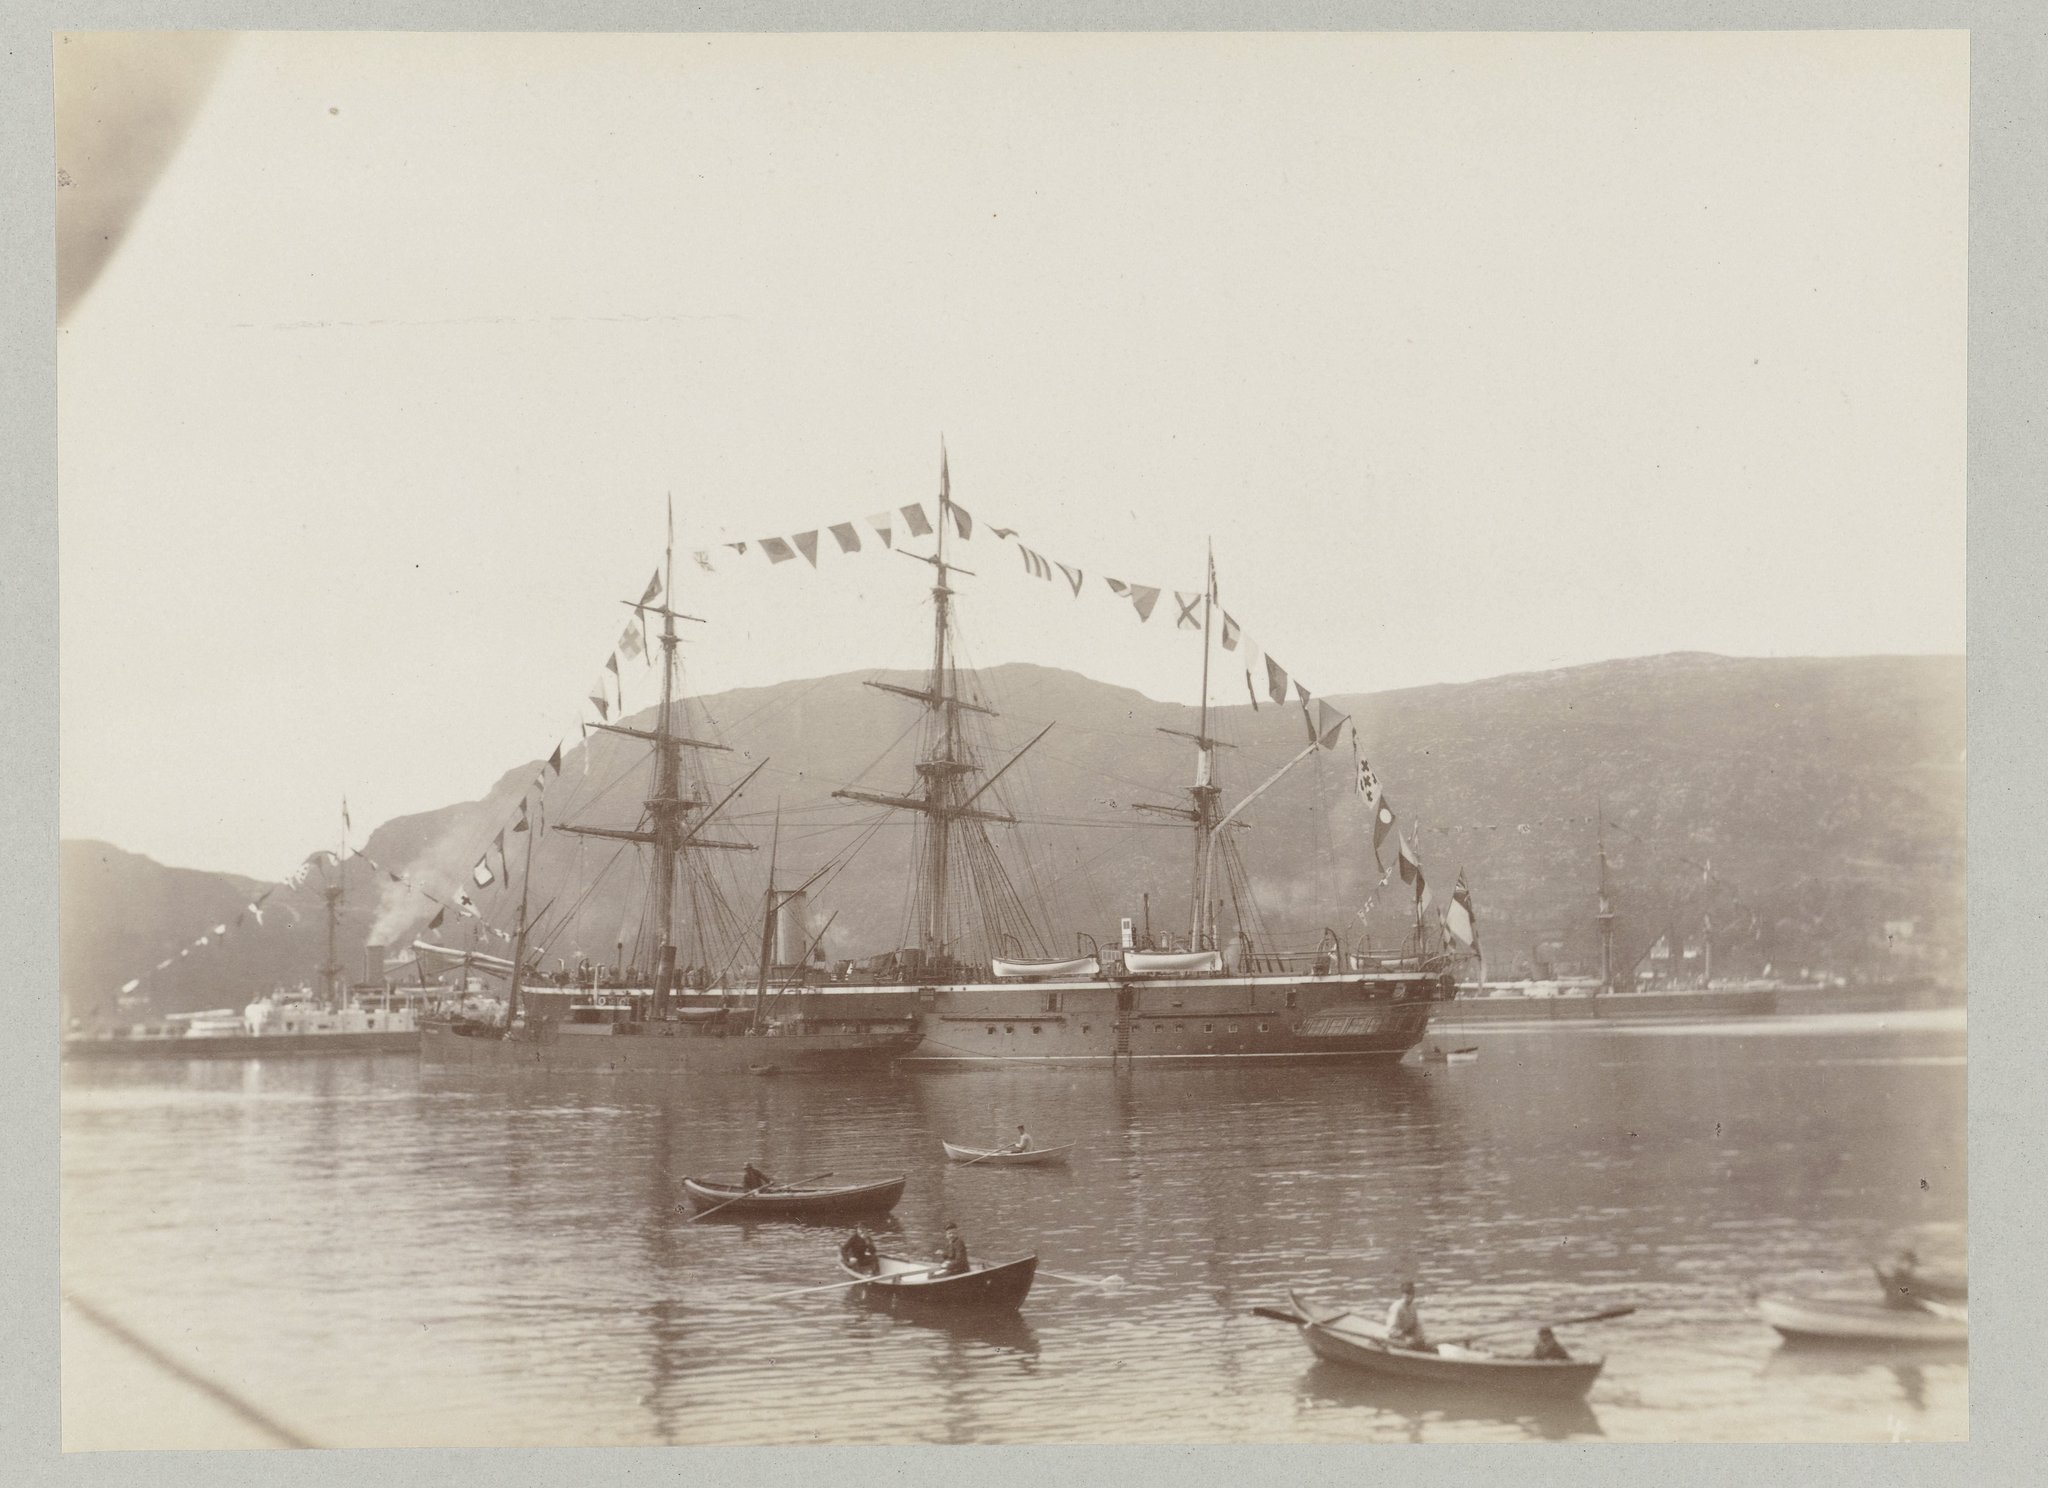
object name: photograph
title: Englisches Geschwader im Hafen von Bergen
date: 1807-1889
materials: cardboard, paper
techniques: albumen print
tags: wilhelm ii (keizer van duitsland), norway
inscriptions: number: ‘4’, number: ‘13’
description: De afdruk van de foto is rond, het papier vierkant